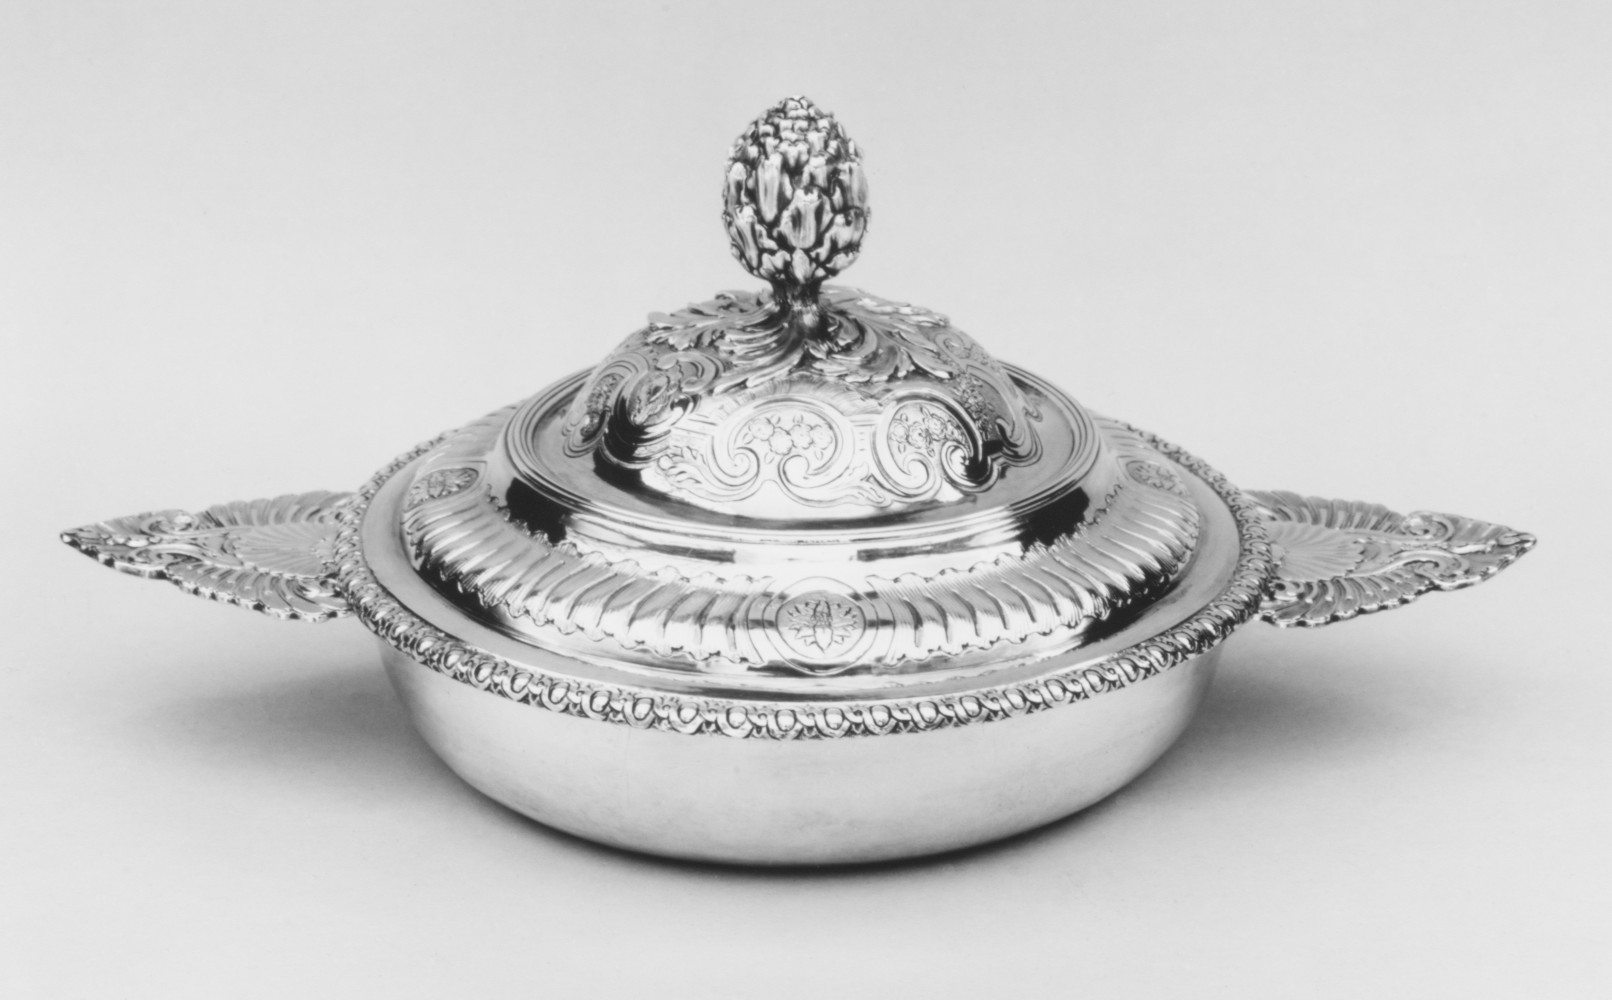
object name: broth bowl with cover écuelle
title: Broth bowl with cover (écuelle)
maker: éloi guérin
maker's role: maker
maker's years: 1704-1765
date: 1749-1750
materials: silver